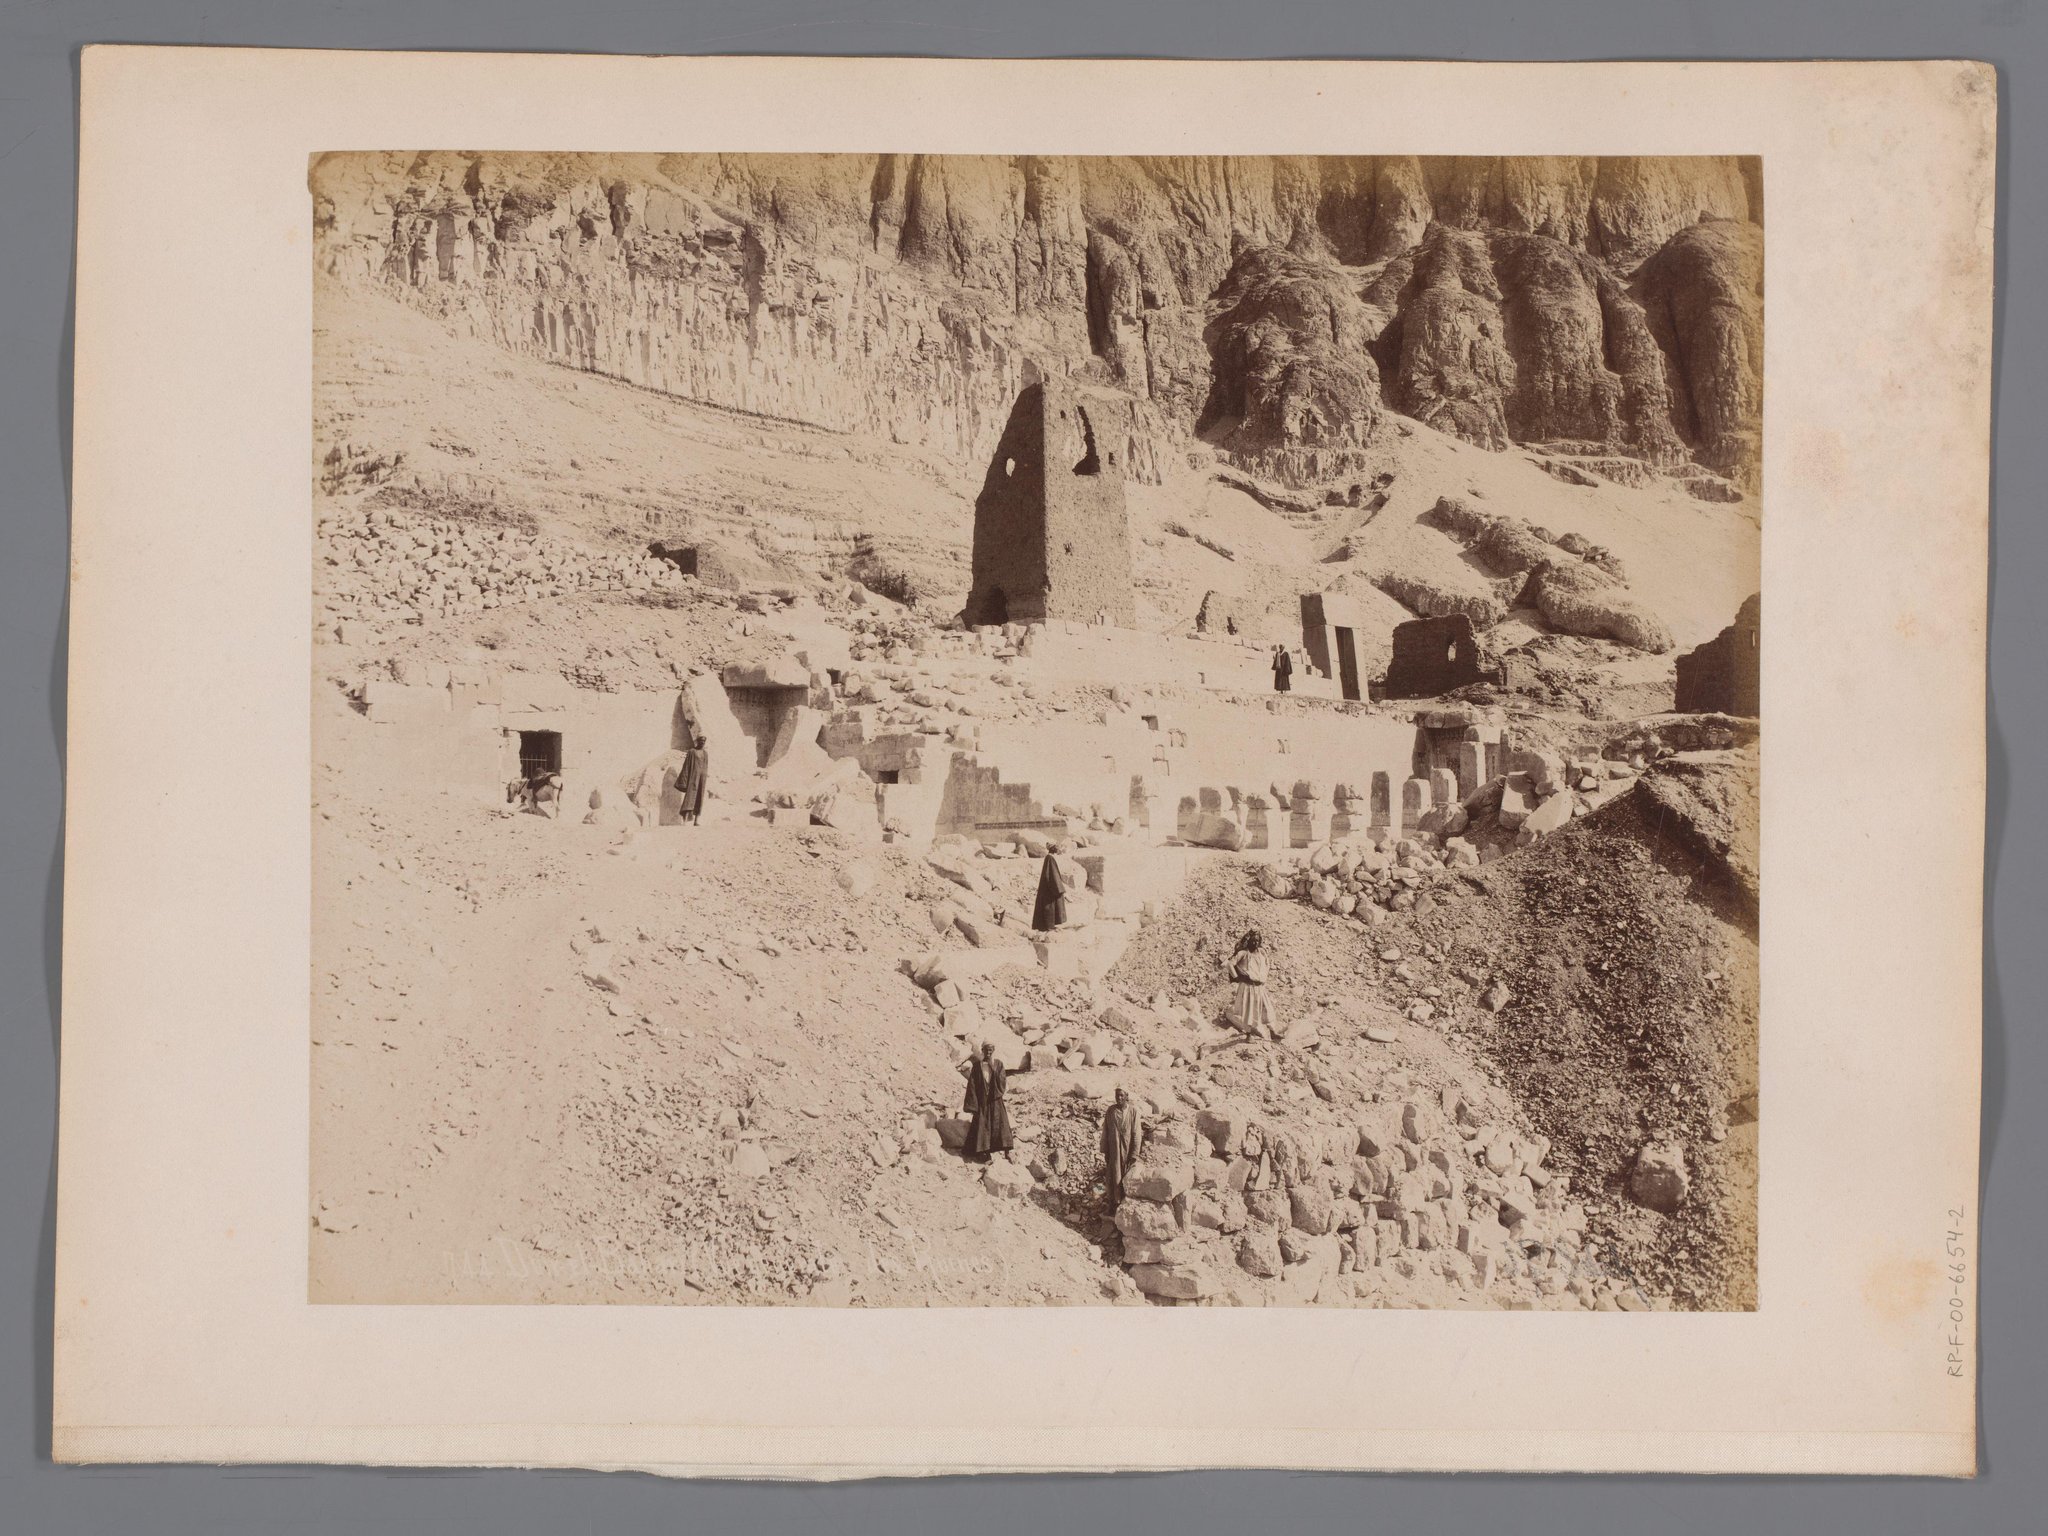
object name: album leaf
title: Ruïnes van Dar-el-Bahar, Safi, Marokko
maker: Anonymous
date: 1880-1900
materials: cardboard, paper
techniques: albumen print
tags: marokko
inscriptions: inscription: ‘Der-el-Bahar (Vue des Ruïnes)’, number: ‘744’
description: Dar-el-Bahar is een Portugese vesting (uit de tijd van de Portugese overheersing van 1488-1541) in de stad Safi aan de westkust van Marokko.